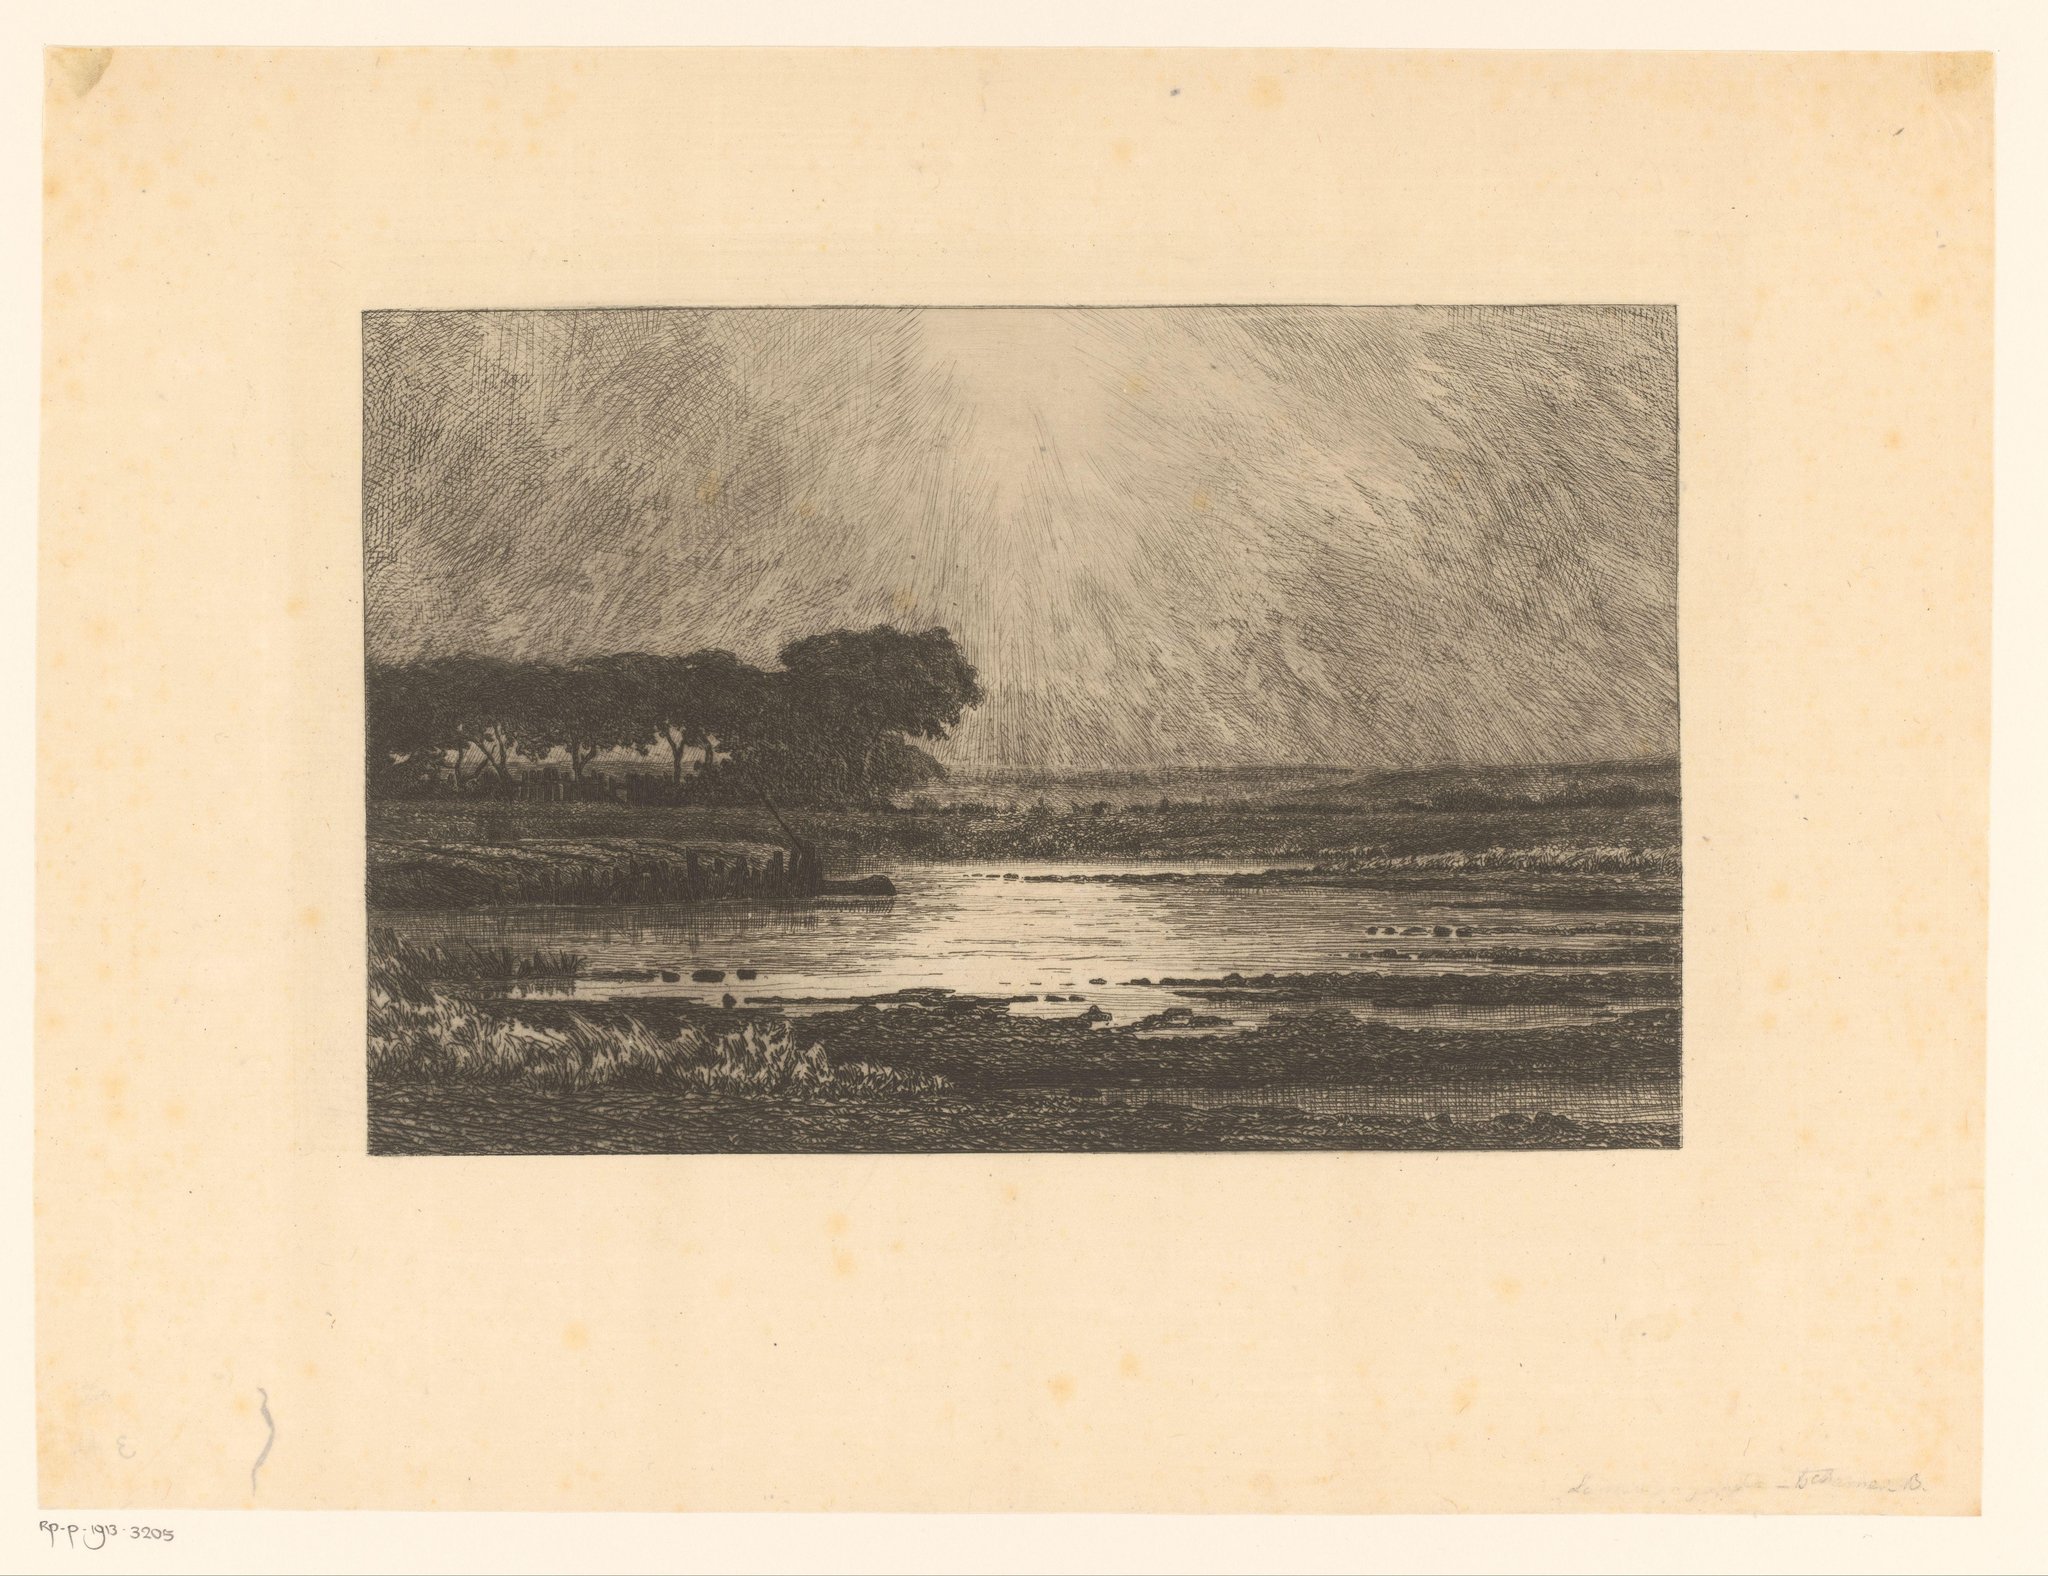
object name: print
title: Gezicht op de Maas bij Jupille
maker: théodore tscharner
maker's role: print maker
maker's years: 1826-1906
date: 1836-1906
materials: paper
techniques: drypoint, etching, intaglio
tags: river, liège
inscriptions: collector's mark: Lugt 2228